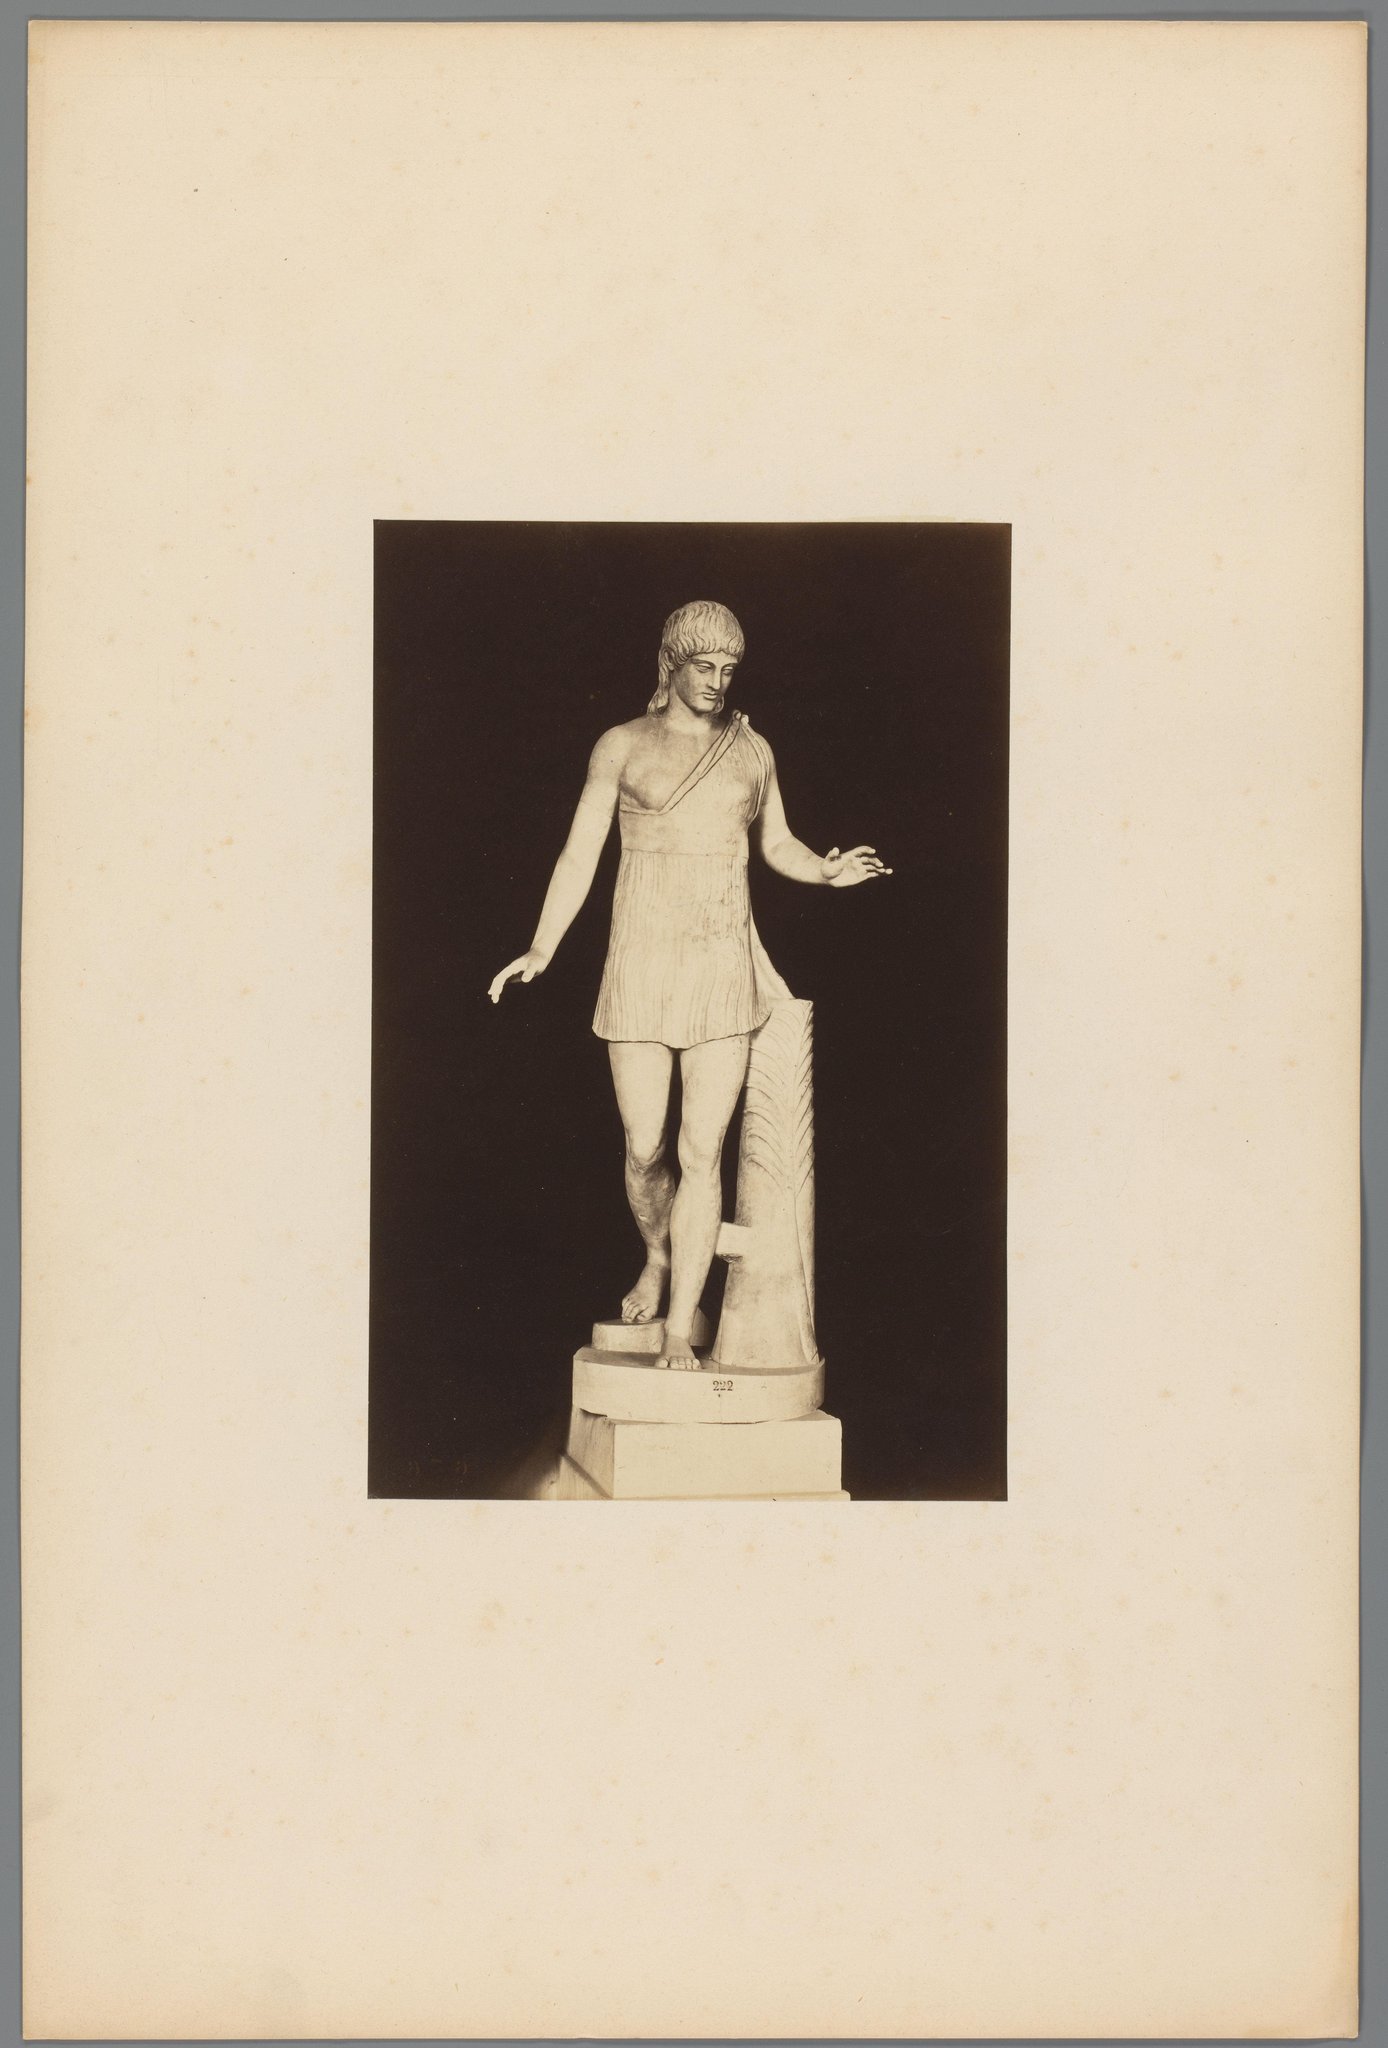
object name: photograph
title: Sculptuur van een Spartaanse atlete tijdens de Heraeaanse Spelen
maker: Anonymous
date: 1851-1900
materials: cardboard, paper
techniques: albumen print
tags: running (~ game), piece of sculpture, reproduction of a piece of sculpture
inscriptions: number: ‘[...]’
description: De Heraeaanse Spelen, gewijd aan de godin Hera waren voor zover bekend de eerste toegestane (en in de geschiedschrijving opgenomen) atletische wedstrijden voor vrouwen. De atlete draagt een chiton die haar rechter borst onbedekt laat, dit was kenmerkend voor de Hereaanse Spelen.